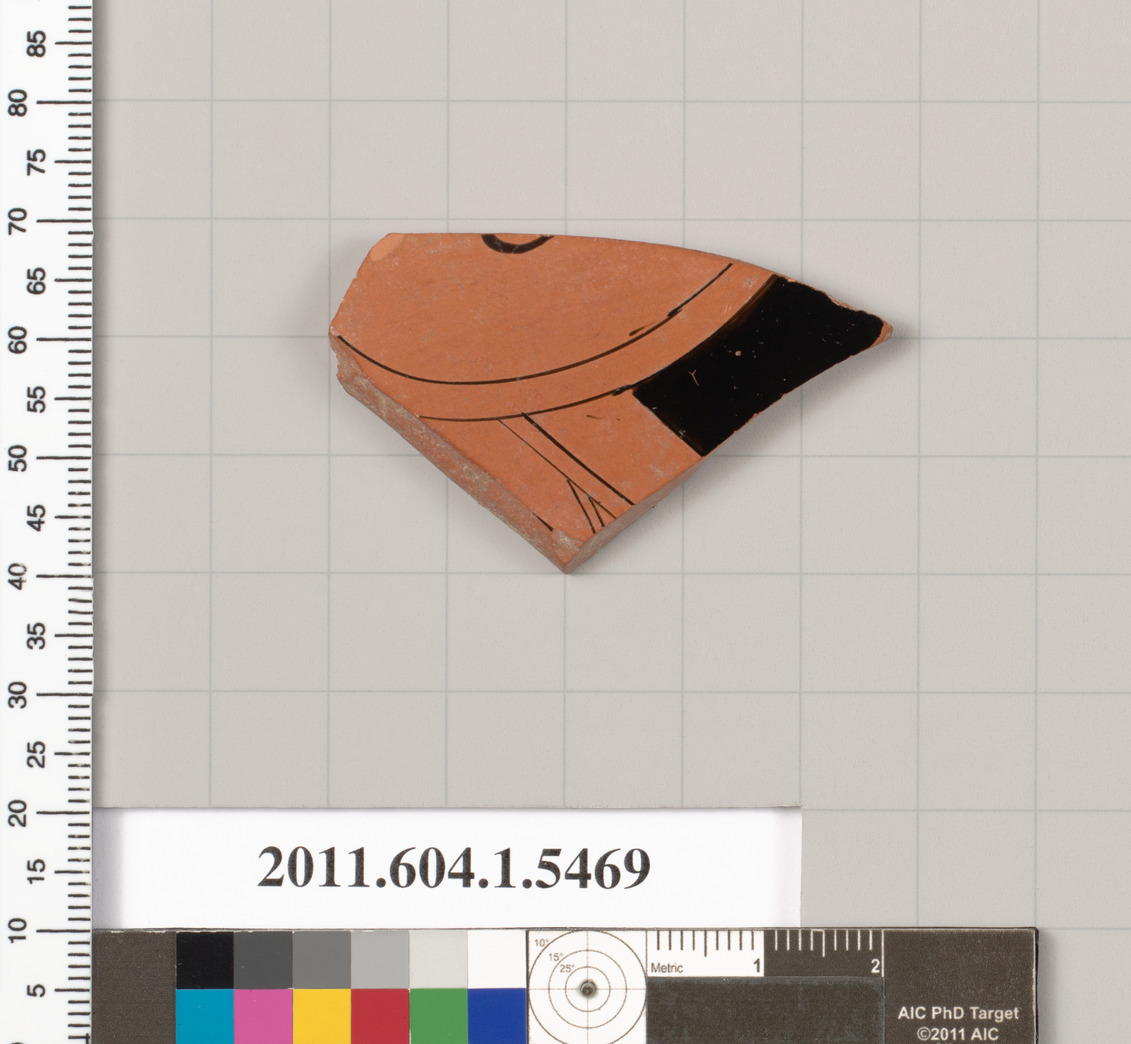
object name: kylix fragment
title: Terracotta fragment of a kylix (drinking cup)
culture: greek, attic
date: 500-480 BCE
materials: terracotta